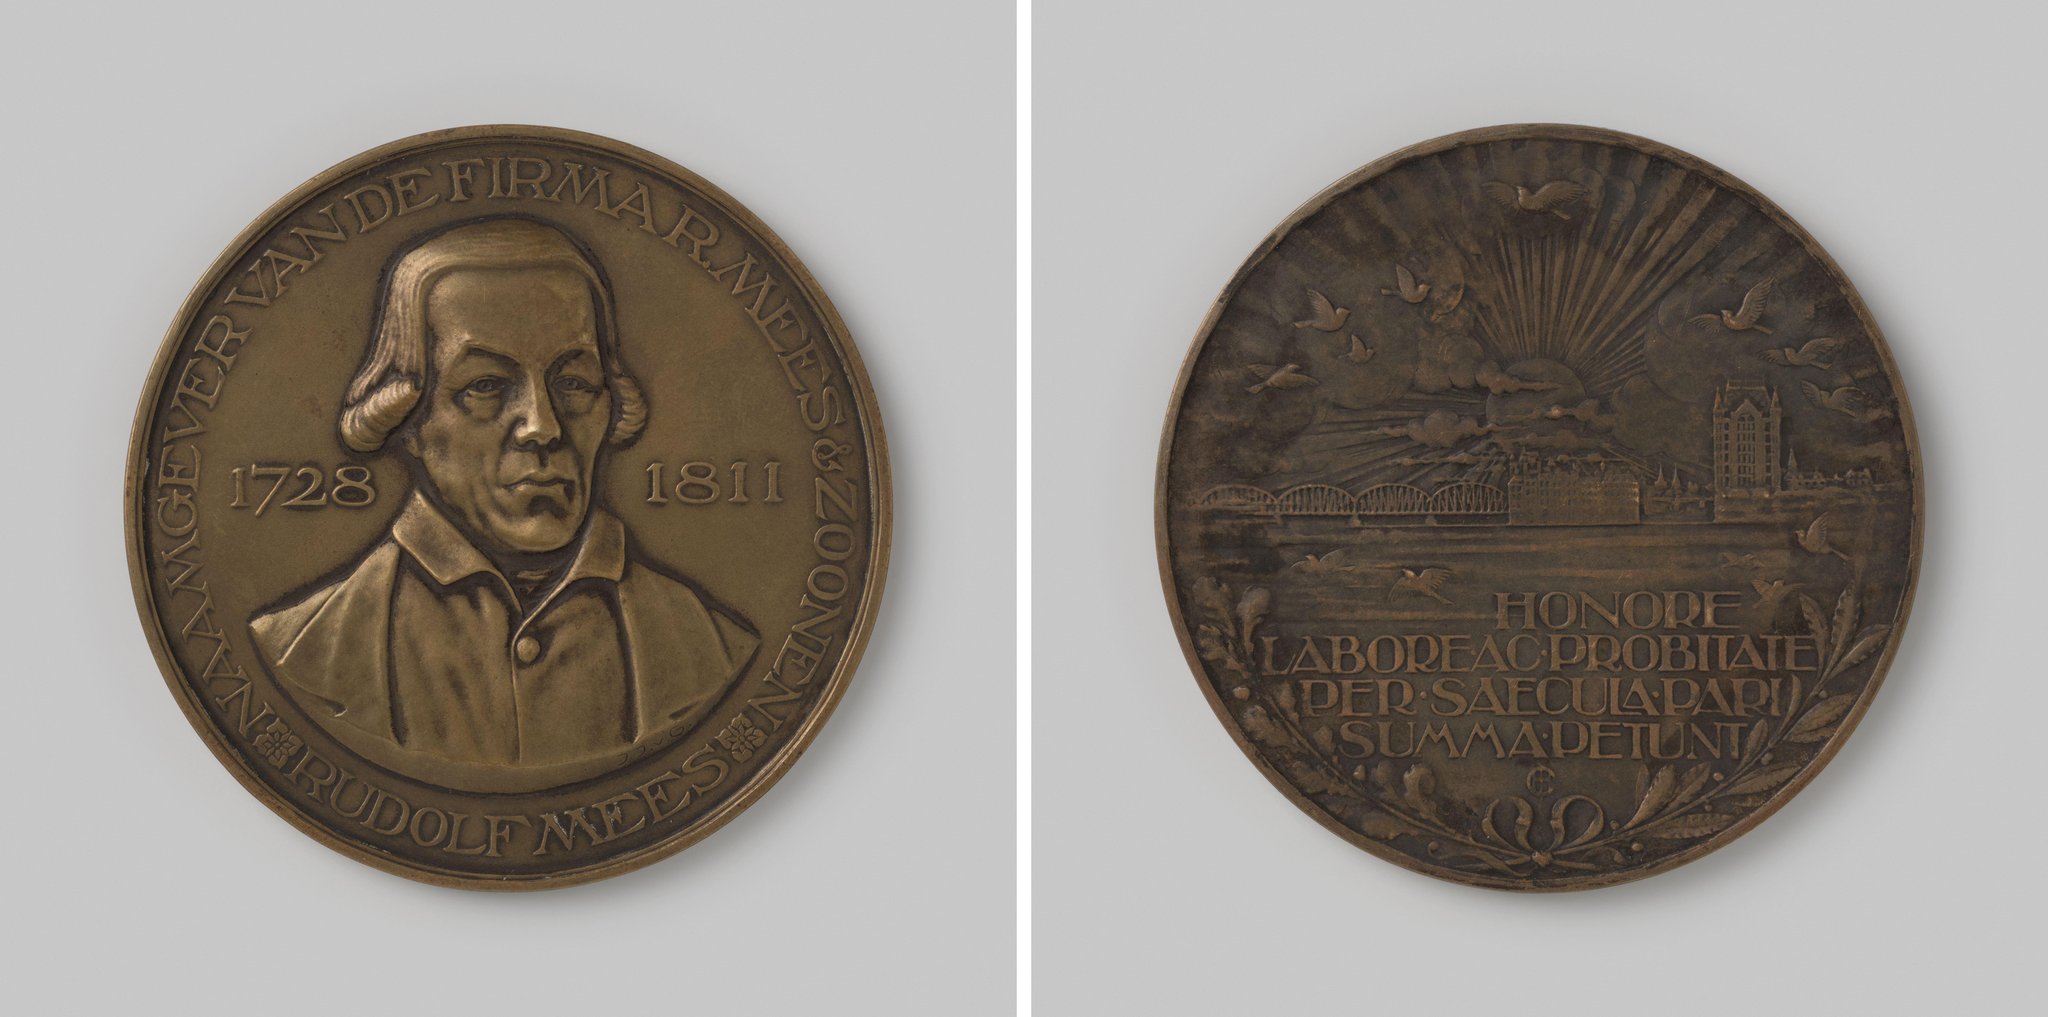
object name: history medal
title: Ter ere van Rudolf Mees bij het tweehonderdjarig bestaan van de firma Mees en Zoonen te Rotterdam 1920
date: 1920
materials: bronze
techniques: striking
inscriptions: inscription: ‘EQTS HONESTS QUI VOCANTUR R. MEES EN ZOONEN II SAEC. INTEGRE PERACTS HOC DONUM OBTULERUNT JAN KALFF EN CO. AMSTELOD. KAL. IAN. MCMXX’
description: Bronzen penning, op de voorzijde het bijna aanziende borstbeeld van Mees tussen twee jaartallen, met omschrift, op de keerzijde Rotterdam in vogelvlucht vanaf het water tegen een stralende opkomende zon, met onderaan vier regels tekst tussen samengestrikte eiken- en lauwertakken, met randinscriptie.